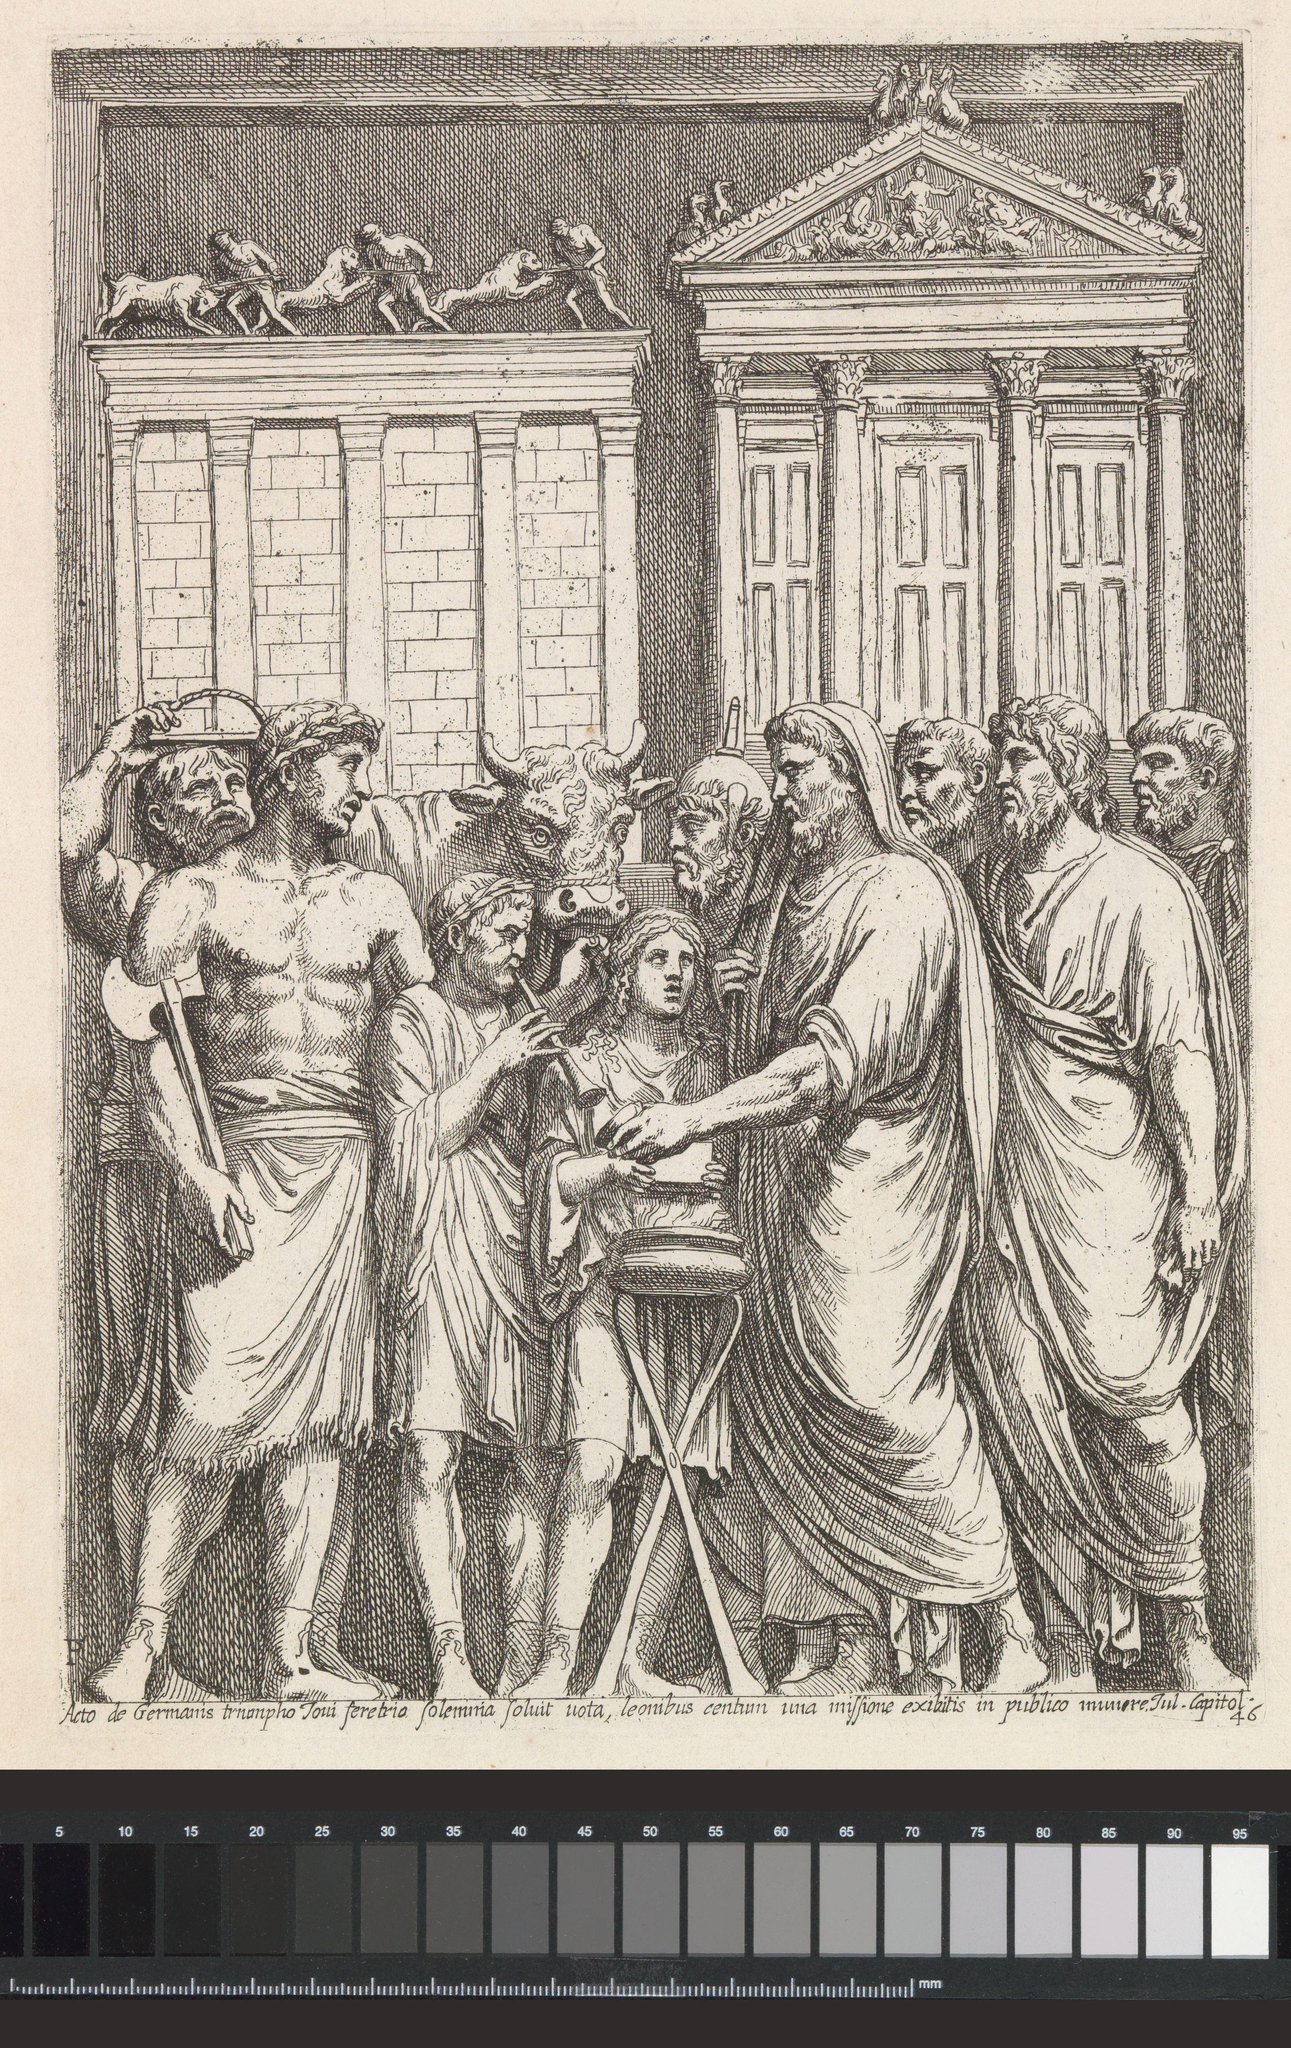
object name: print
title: Romeinse gebeeldhouwde reliëfs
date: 1645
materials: paper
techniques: etching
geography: paris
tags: rome, animal sacrifice ~ roman religion, piece of sculpture, reproduction of a piece of sculpture, temple, shrine ~ roman religion, ruler, sovereign, ox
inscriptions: inscription: ‘Ende lib. No. 6. tom. 1. No. 23. 24. 50.’, number: ‘73’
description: Deze prent maakt deel uit van een reeks van 54 prenten (+ titelprent) naar antieke reliëfs. De nummering op de prenten loopt van 1 tot en met 50. Sommige prenten hebben dubbele nummers. Naar een reliëf in het Palazzo dei Conservatori te Rome.